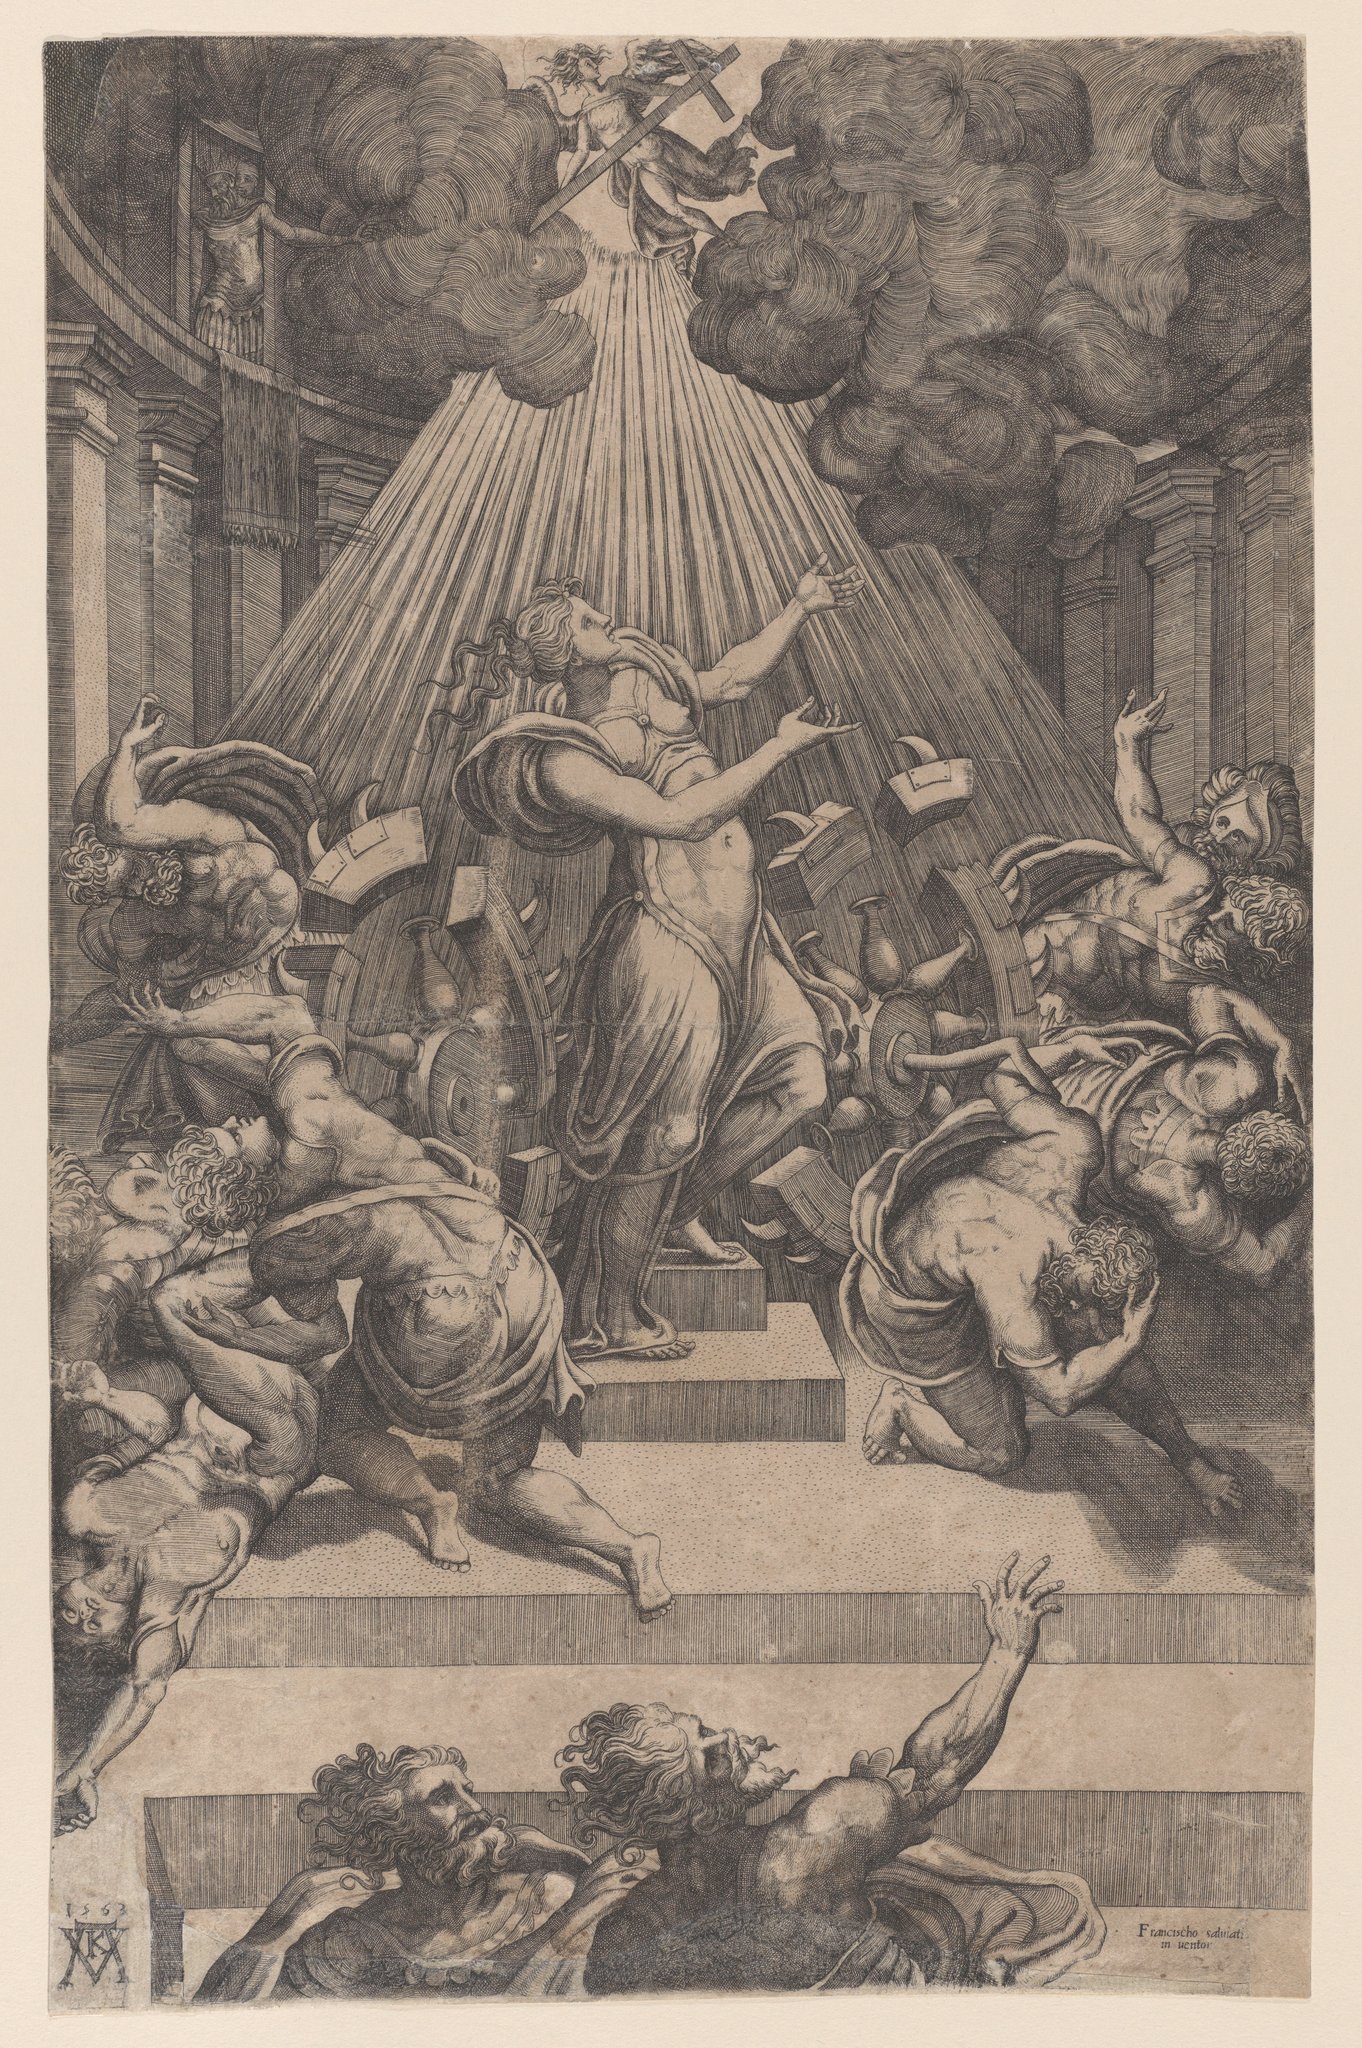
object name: print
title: The Martyrdom of Saint Catherine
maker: mario cartaro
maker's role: artist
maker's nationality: italian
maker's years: 1557-1620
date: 1563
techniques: engraving